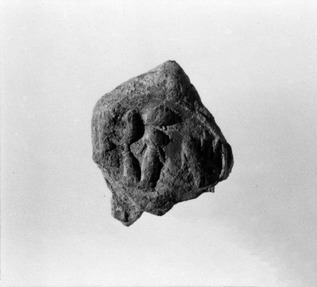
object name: sealing, nebmaatre, amenhotep iii, lower egypt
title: Document Sealing With the Throne Name of Amenhotep III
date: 1390-1352 BCE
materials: mud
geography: egypt